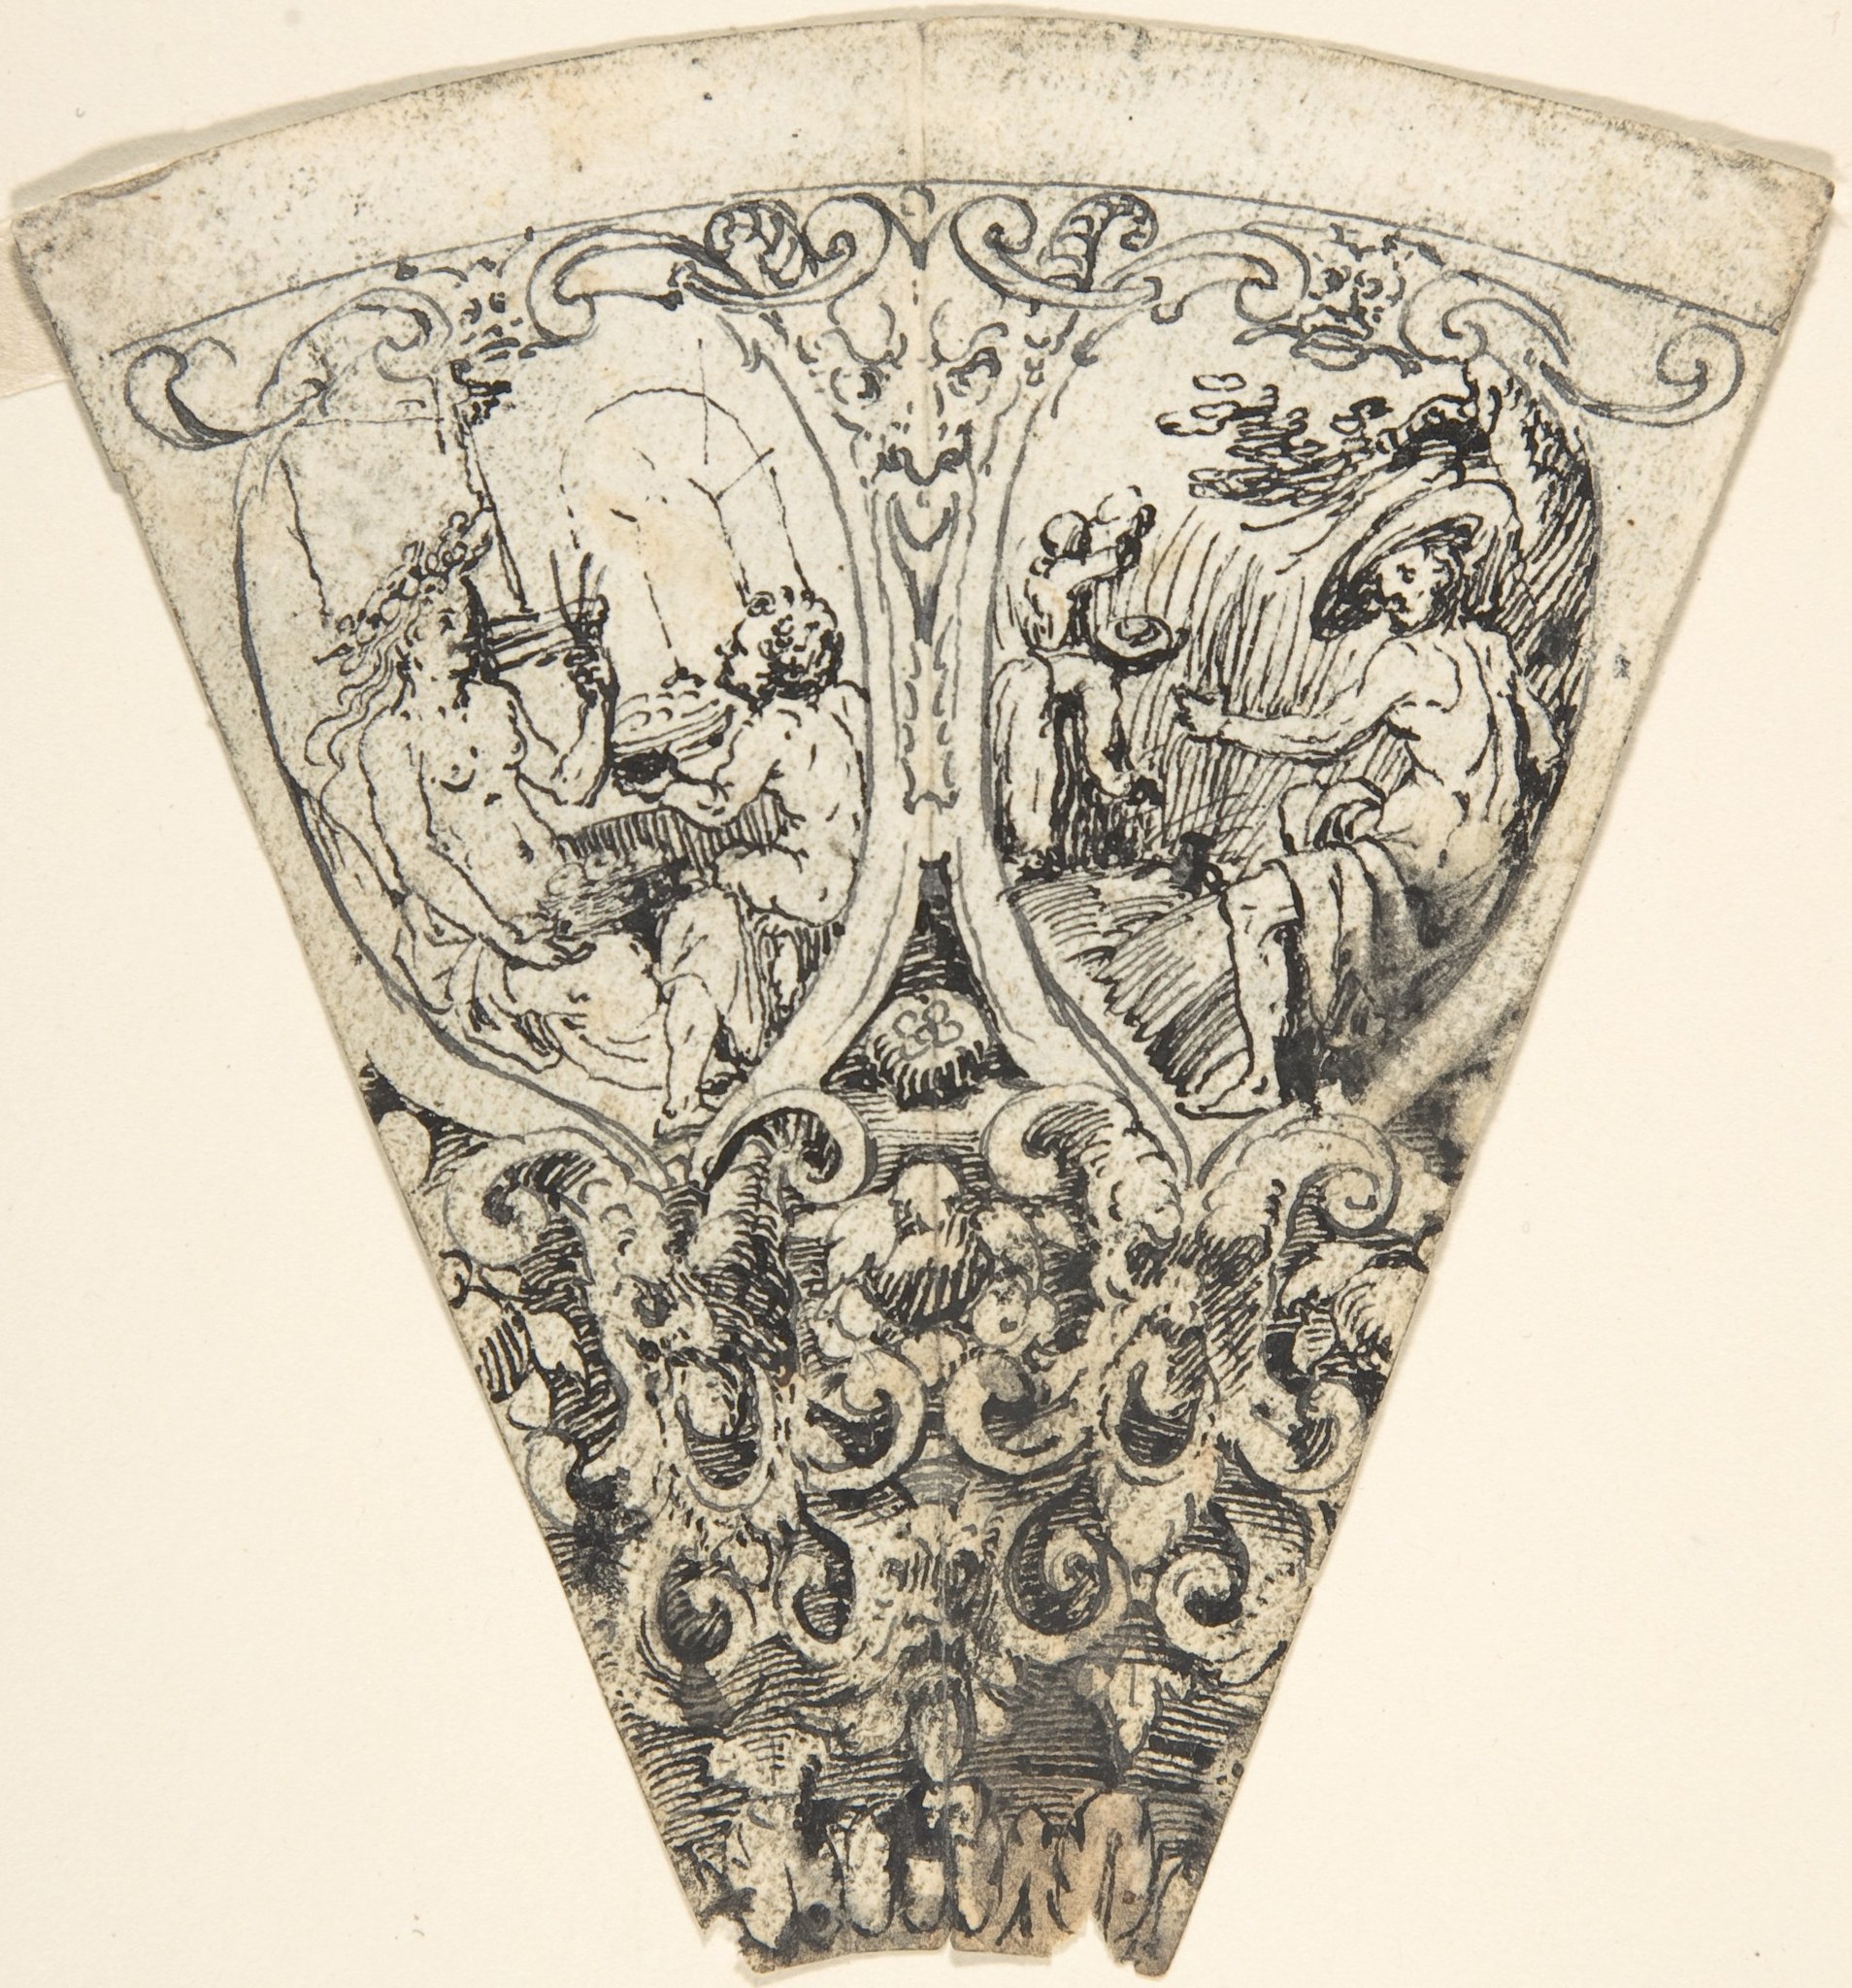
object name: drawing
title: Design for a Cup(?)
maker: anonymous, german, 19th century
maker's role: artist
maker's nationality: german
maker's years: 1800-1899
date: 1801-1900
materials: ink, paper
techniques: incising, pen, transfer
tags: male nudes,female nudes